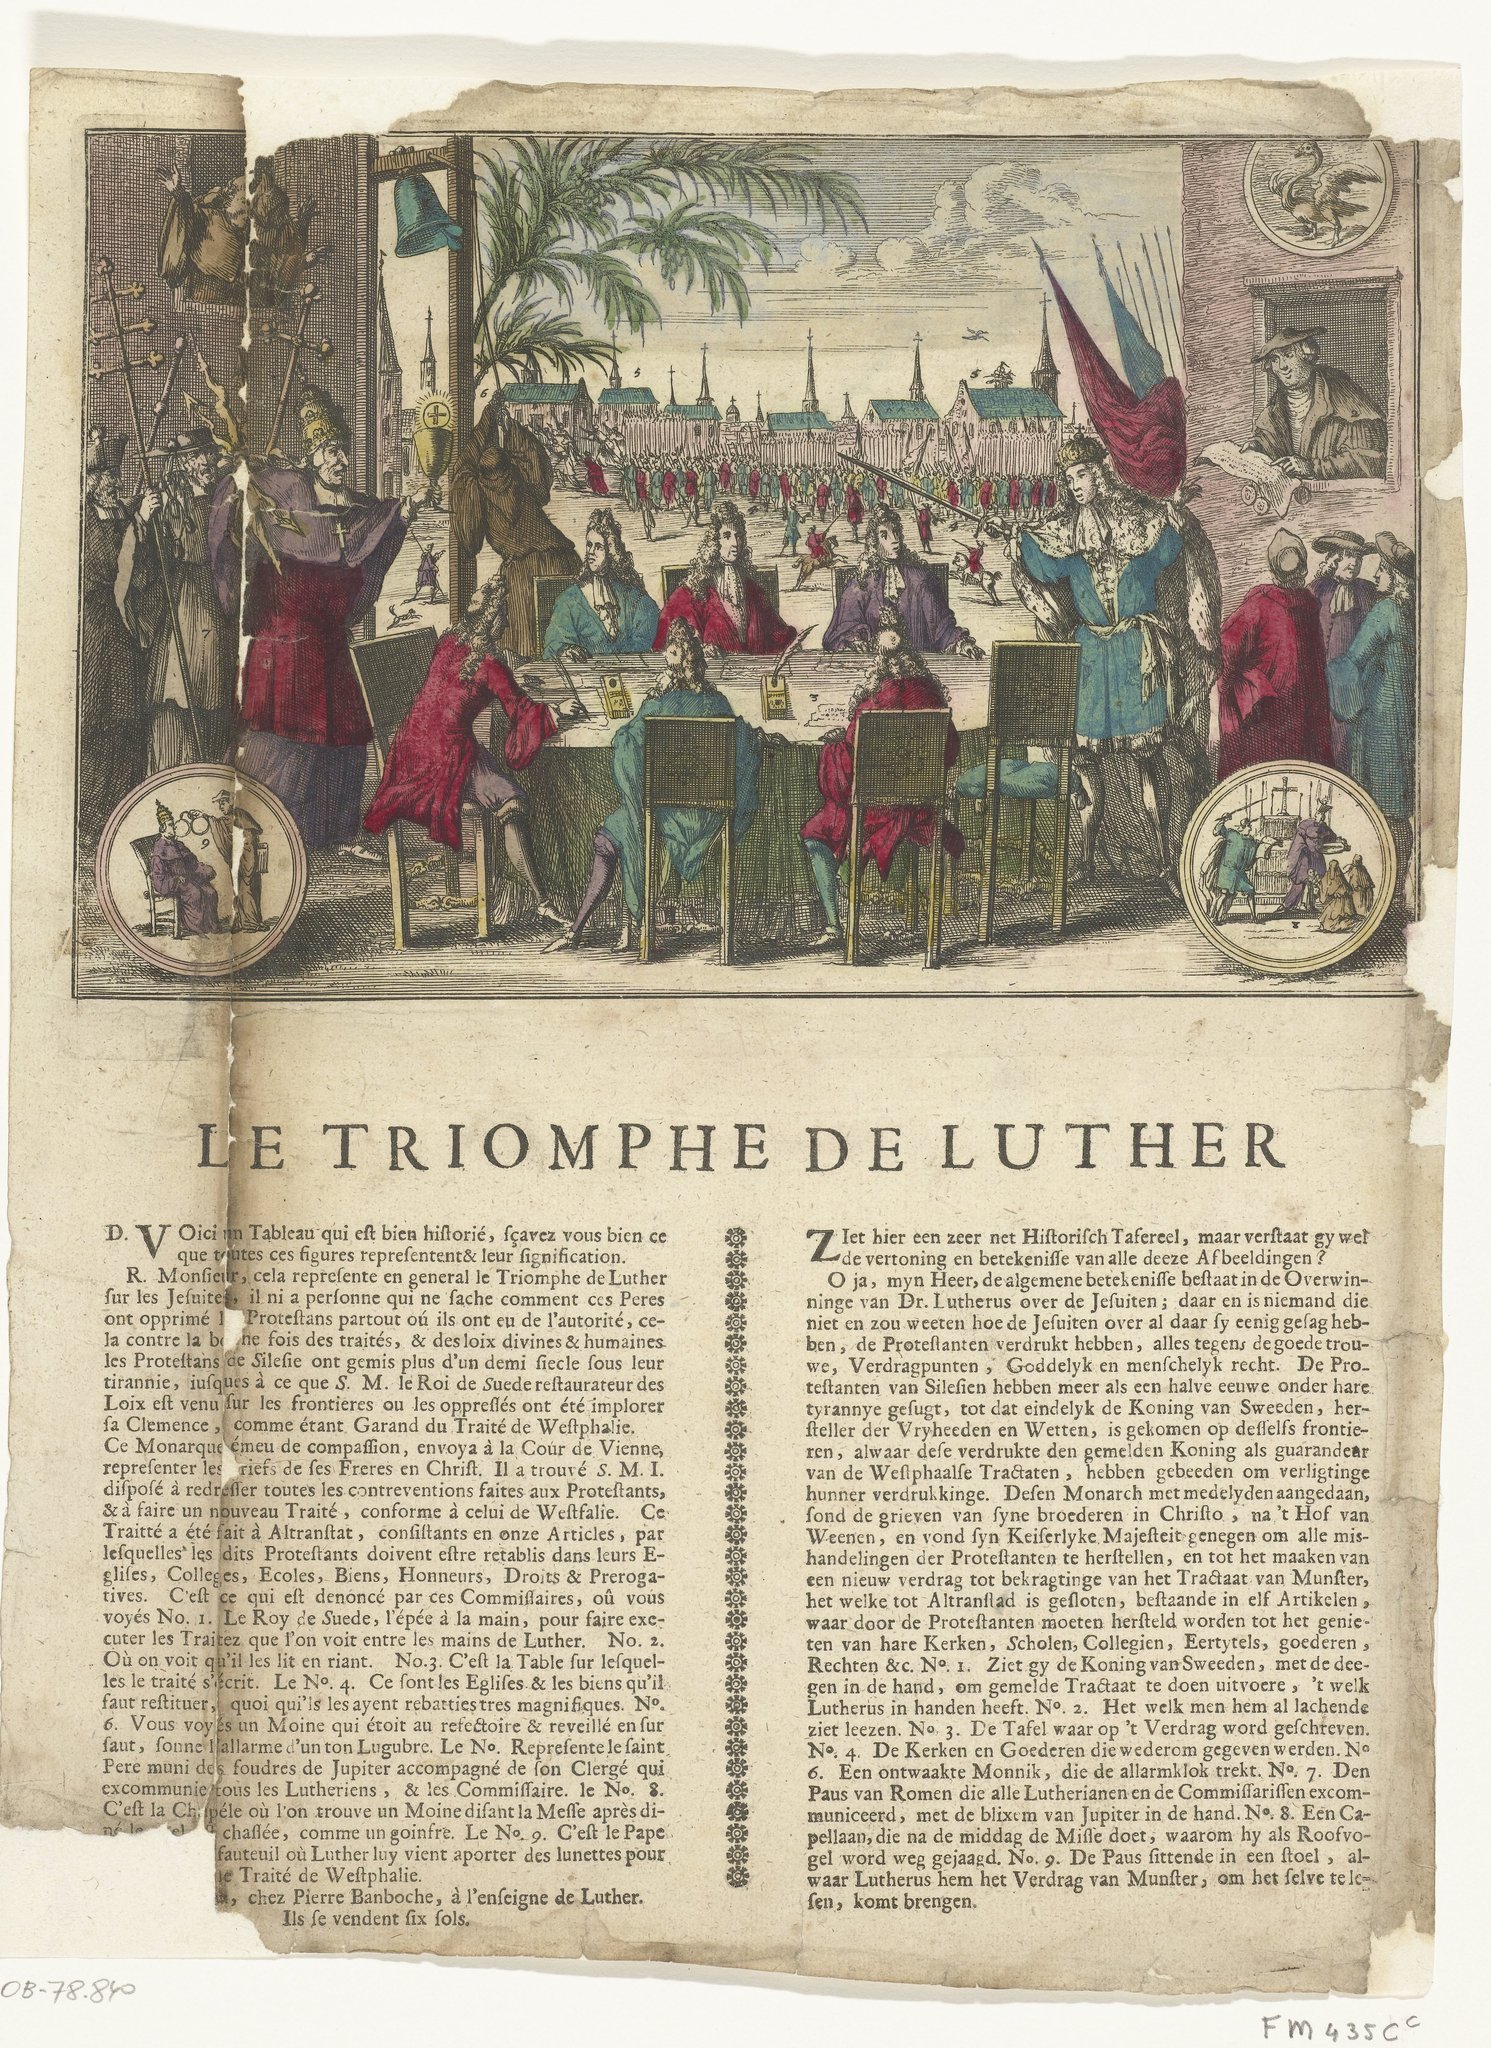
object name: print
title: Triomf van Luther, 1707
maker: Anonymous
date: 1707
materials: paper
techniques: etching, hand coloring, letterpress printing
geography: northern netherlands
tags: priest, martin luther, rome, clergyman, clemens xi, signing of peace treaty, concluding the peace, political caricatures and satires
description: Triomf van Luther, ca. 1707. Koning Karel XII van Zweden komt op voor het herstel van de rechten van de lutheranen volgens het verdrag van Altranstädt, 1707. De koning staat aan het hoofd van een tafel waaraan het verdrag getekend wordt en wijst met zijn zwaard naar een razende paus aan de linker kant van de tafel. Rechts kijkt Martin Luther vanuit een venster glimlachend toe. Onder de plaat 2 kolommen tekst in het Frans en Nederlands. Spotprent op de paus en de Roomse kerk.